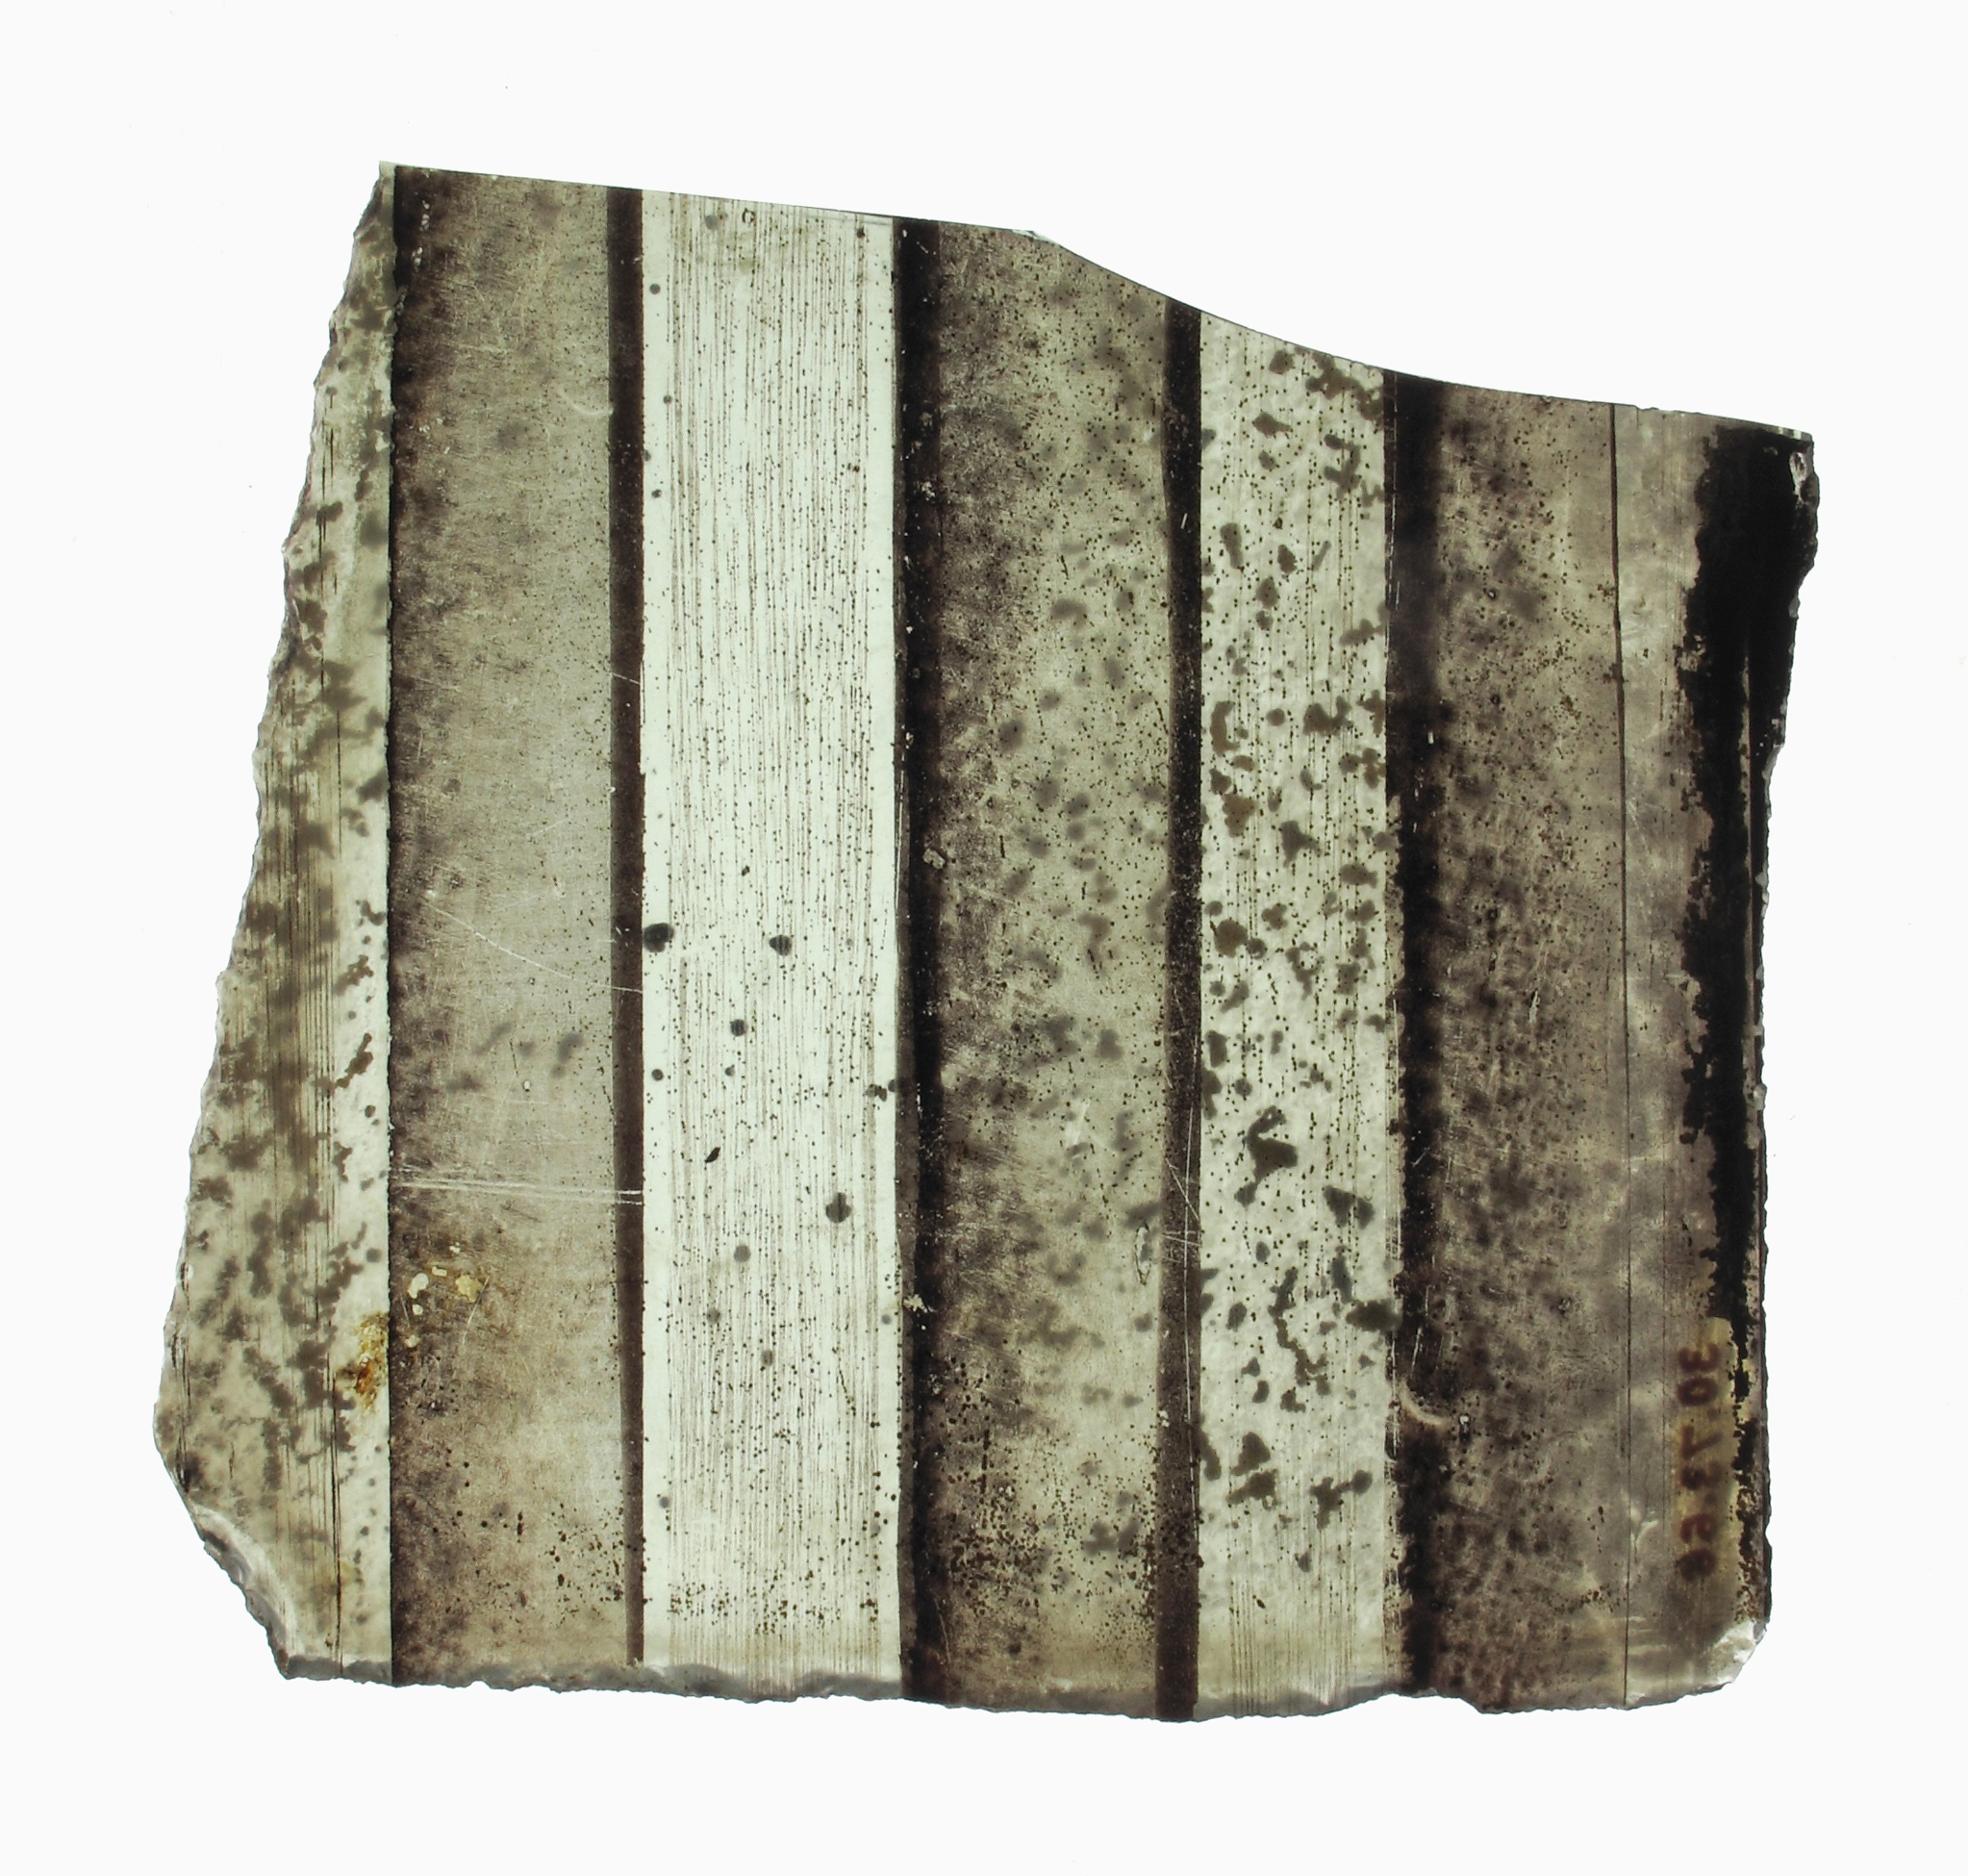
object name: fragment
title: Glass Fragment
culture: european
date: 1401-1500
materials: glass